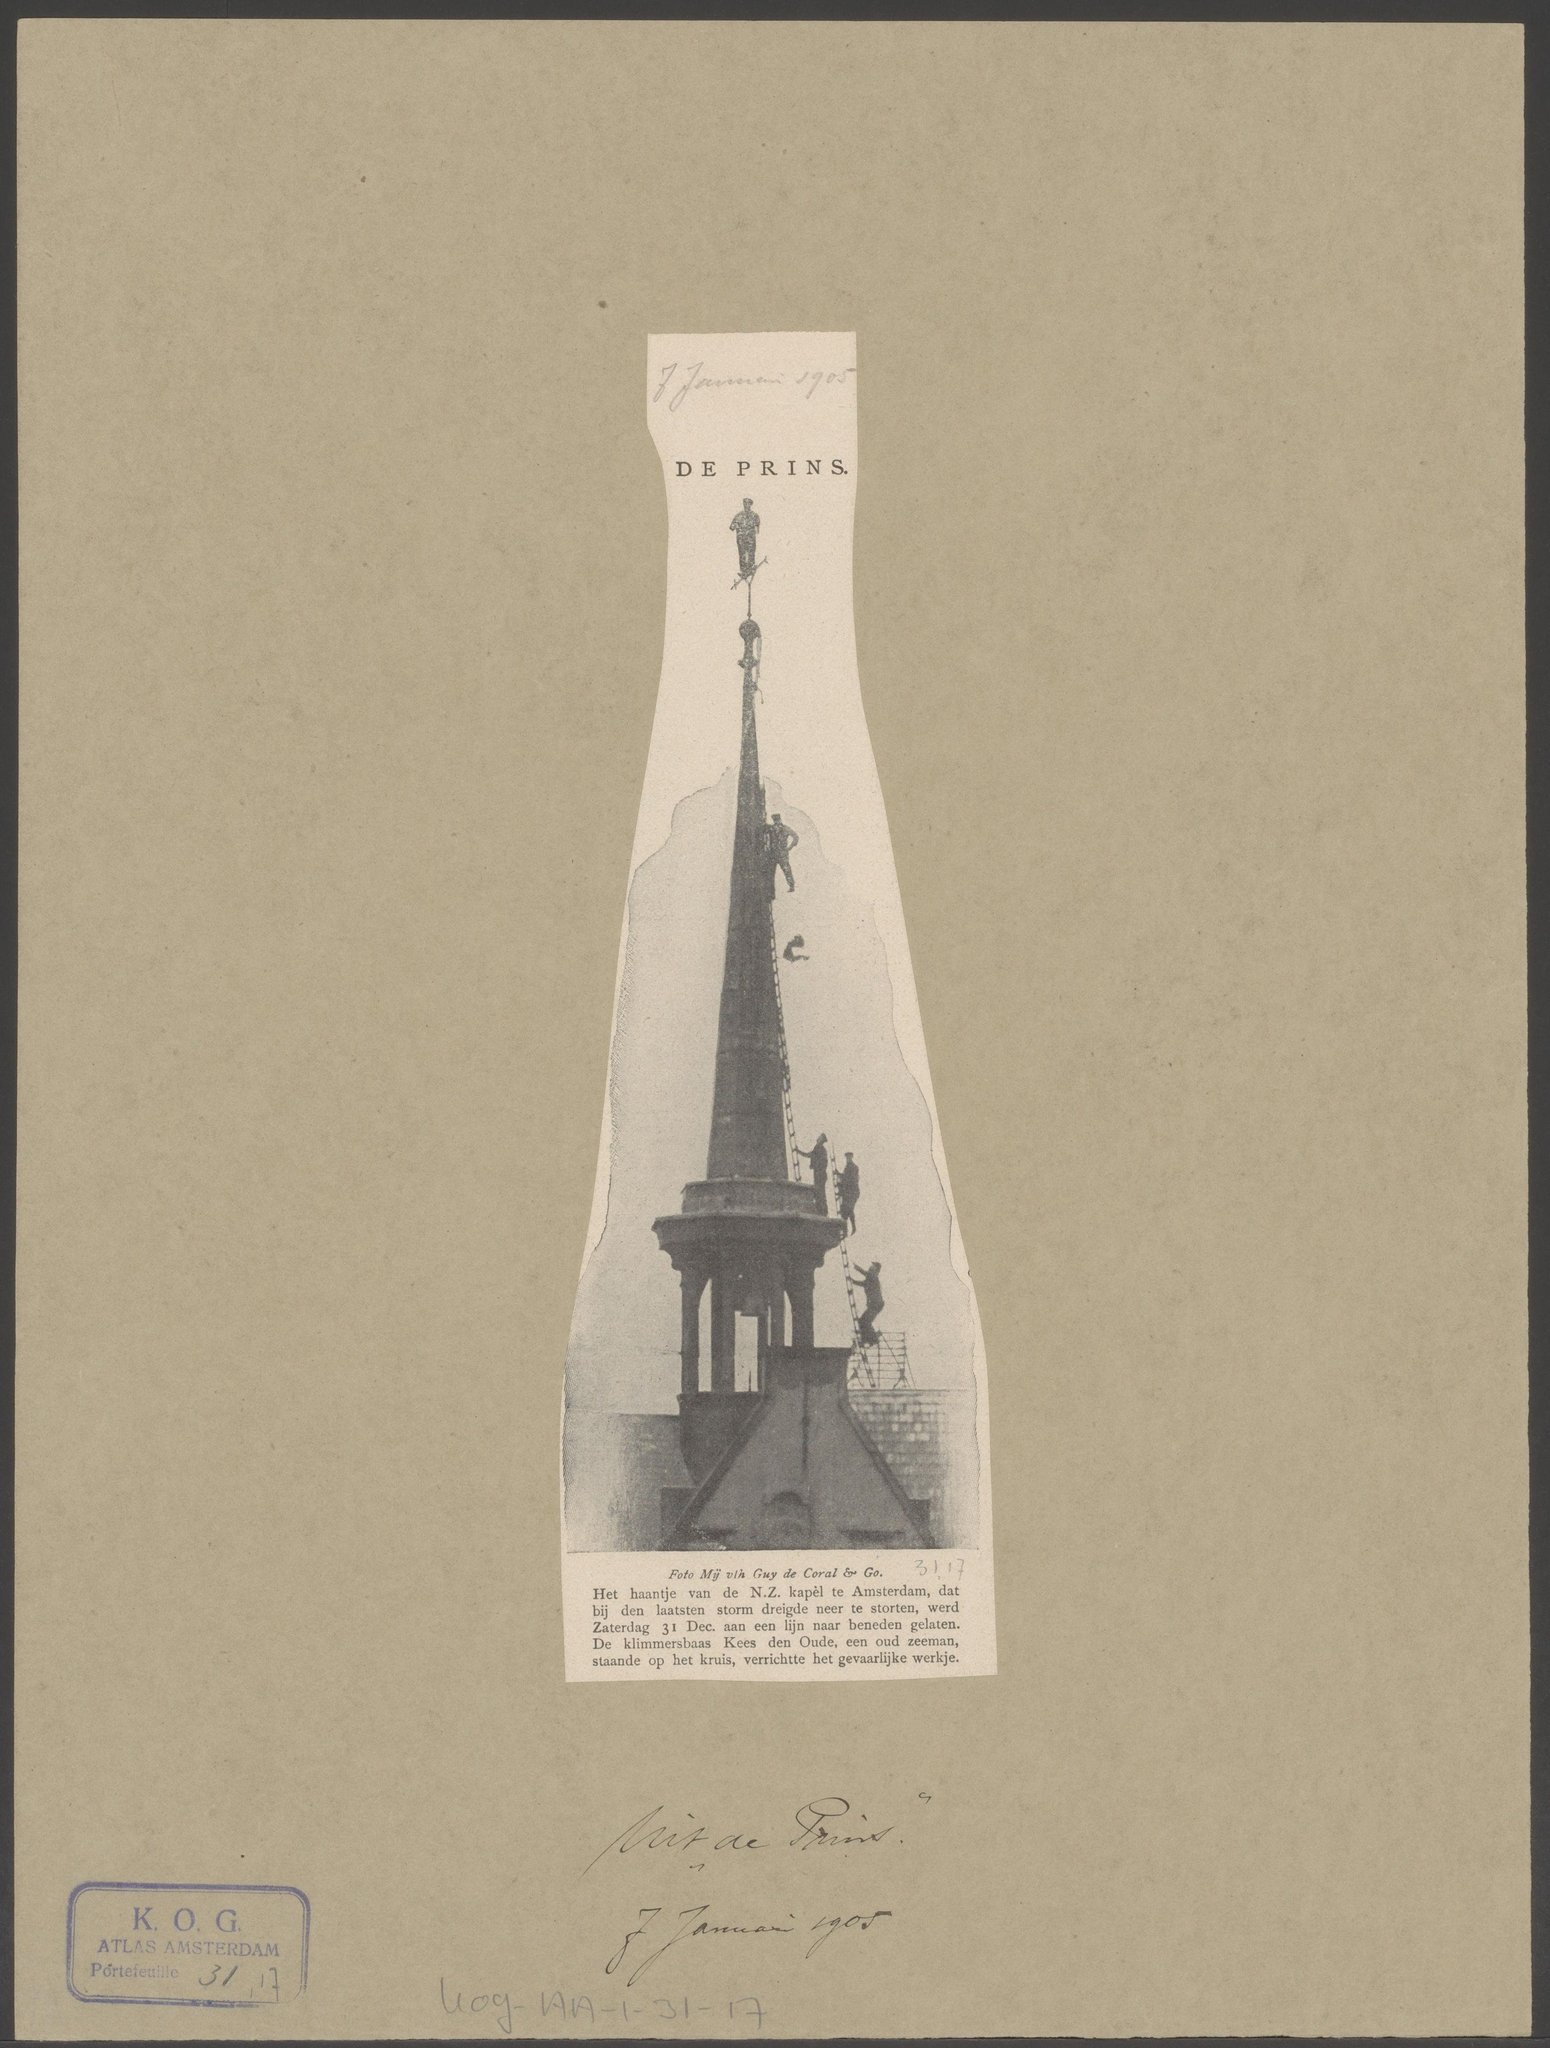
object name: photomechanical print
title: Toren van de Nieuwezijds Kapel te Amsterdam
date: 1905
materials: paper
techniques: letterpress printing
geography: amsterdam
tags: weathercock, climbing, parts of church exterior and annexes: tower - qq - small church, chapel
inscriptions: collector's mark: Lugt 1641b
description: Onderwerpsrubriek binnen de Atlas Amsterdam: Kerkwezen: Hervormde Gemeente: Nieuwezijds Kapel.